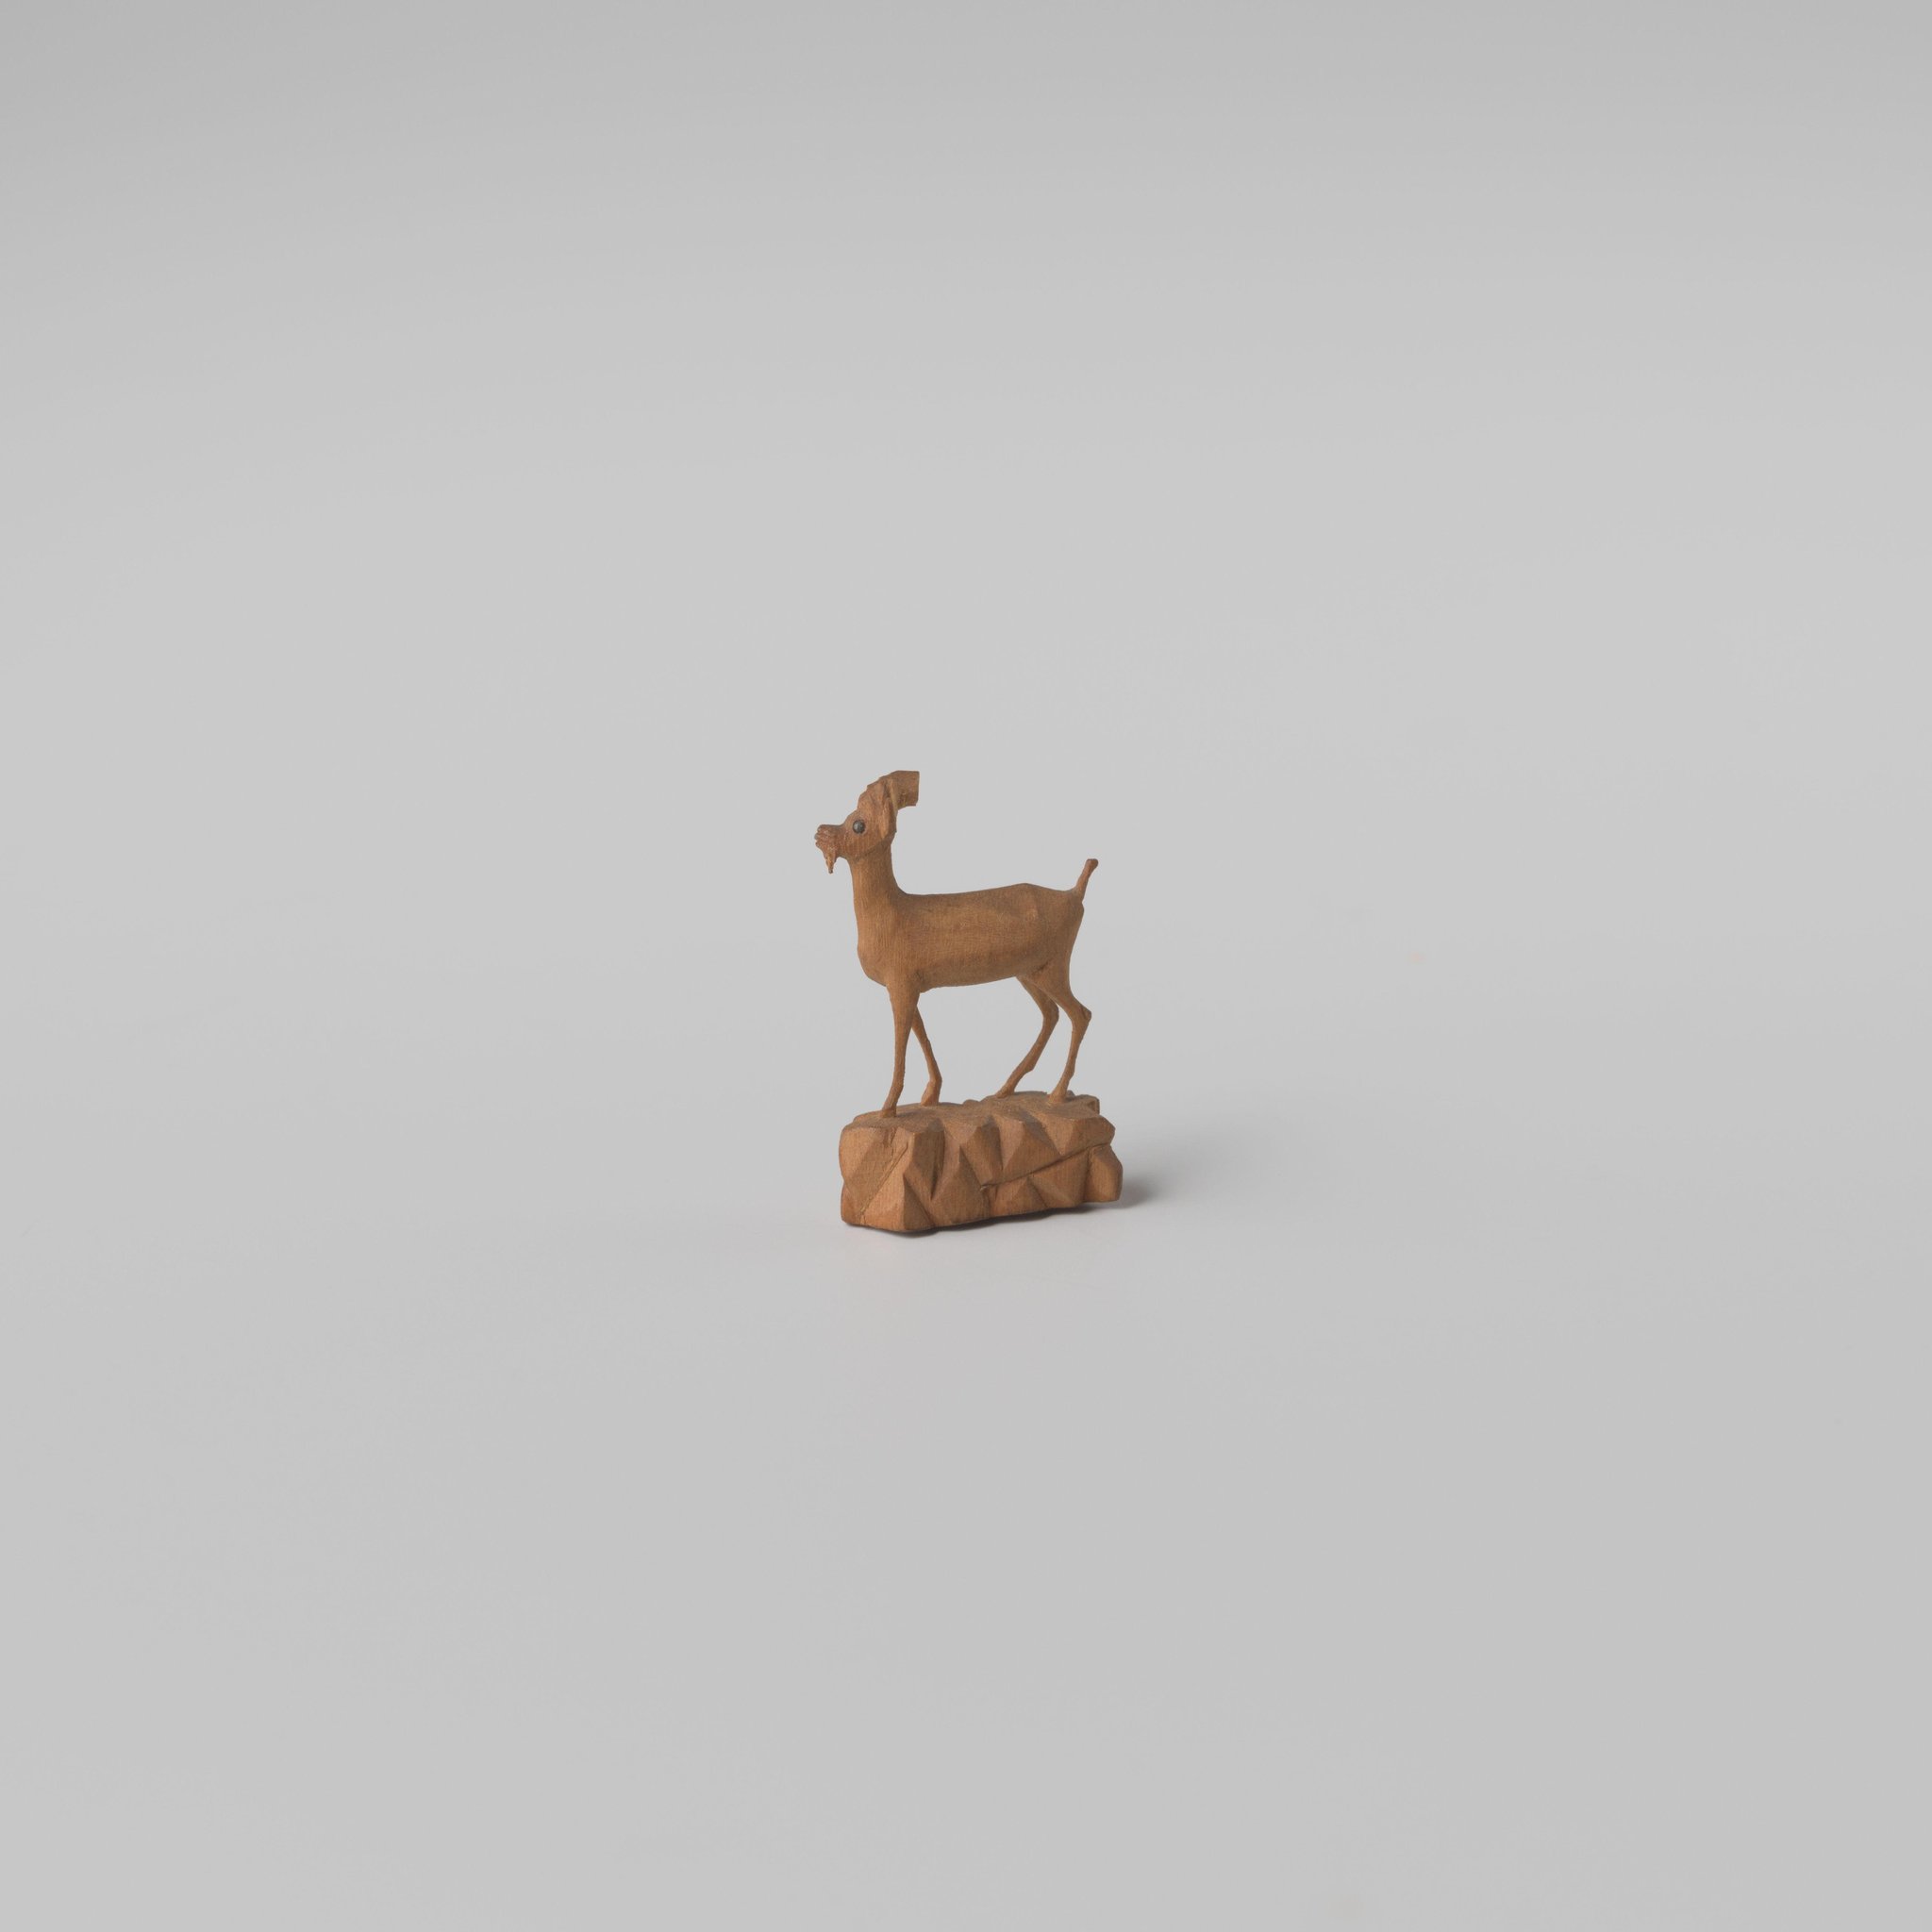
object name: dierfiguur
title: Bok, staande op bergplateau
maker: Anonymous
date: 1800-1899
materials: wood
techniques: cutting, painted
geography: germany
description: Bok, staande op een bergplateau, gesneden uit blank esdoornhout.